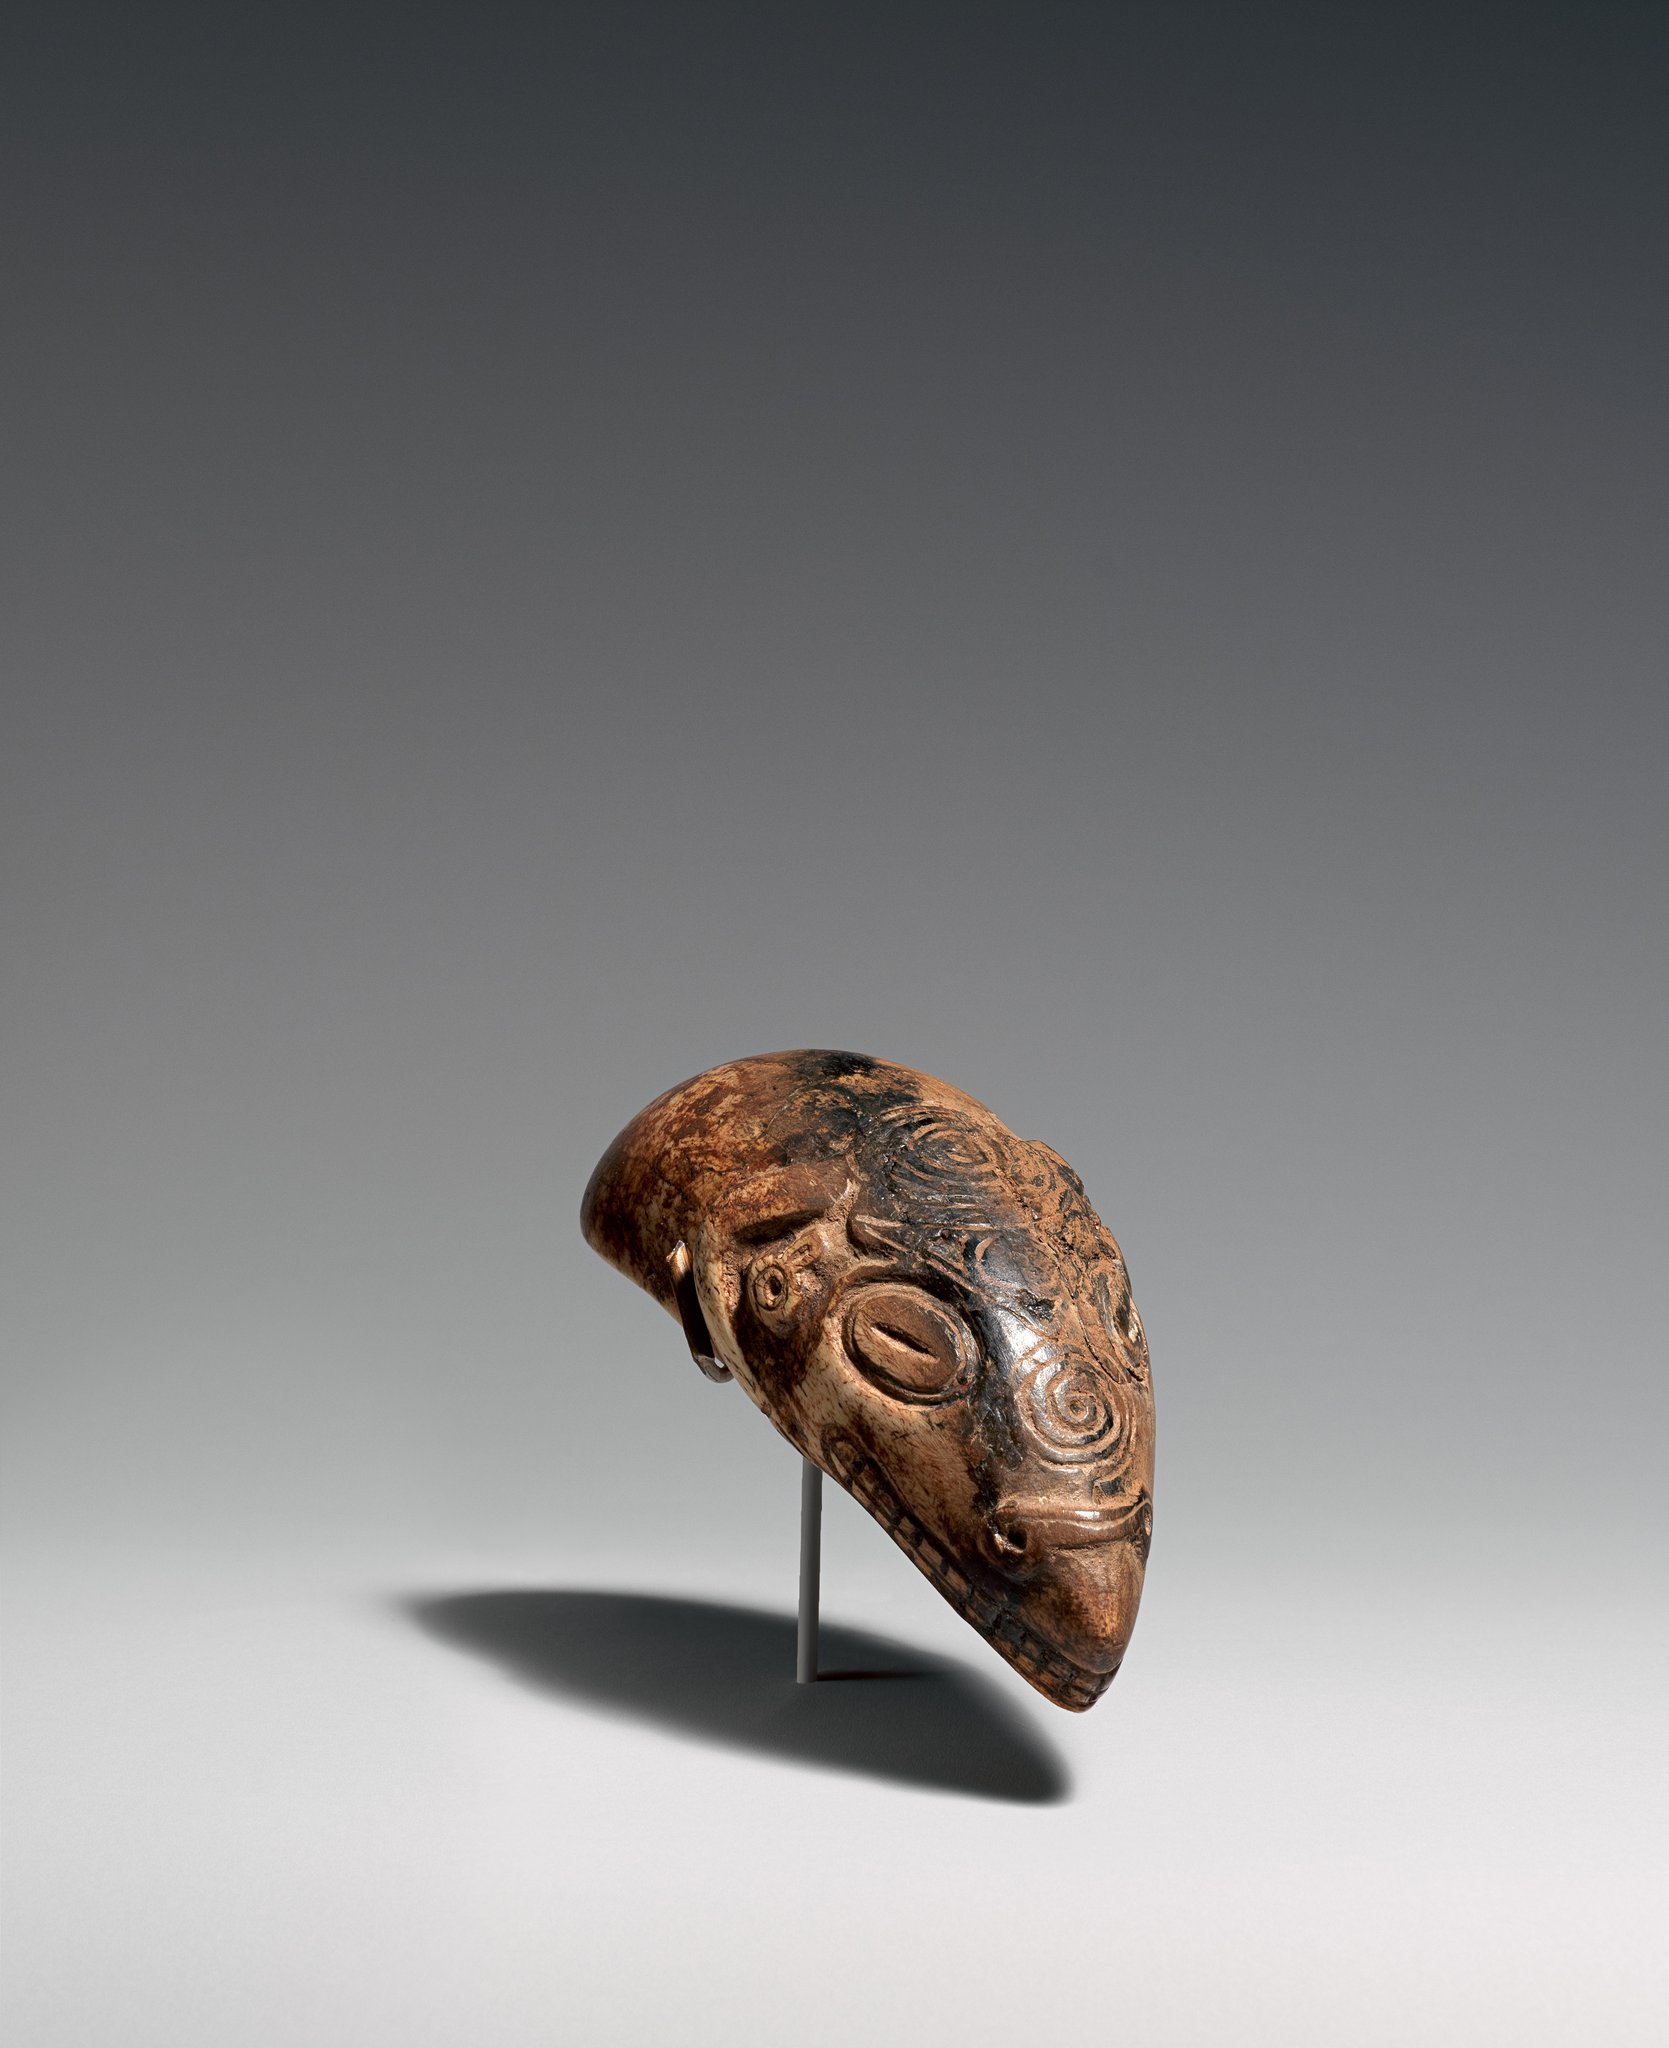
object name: spoon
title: Lizard-Head Spoon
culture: taíno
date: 1201-1500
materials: bone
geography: dominican republic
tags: lizards